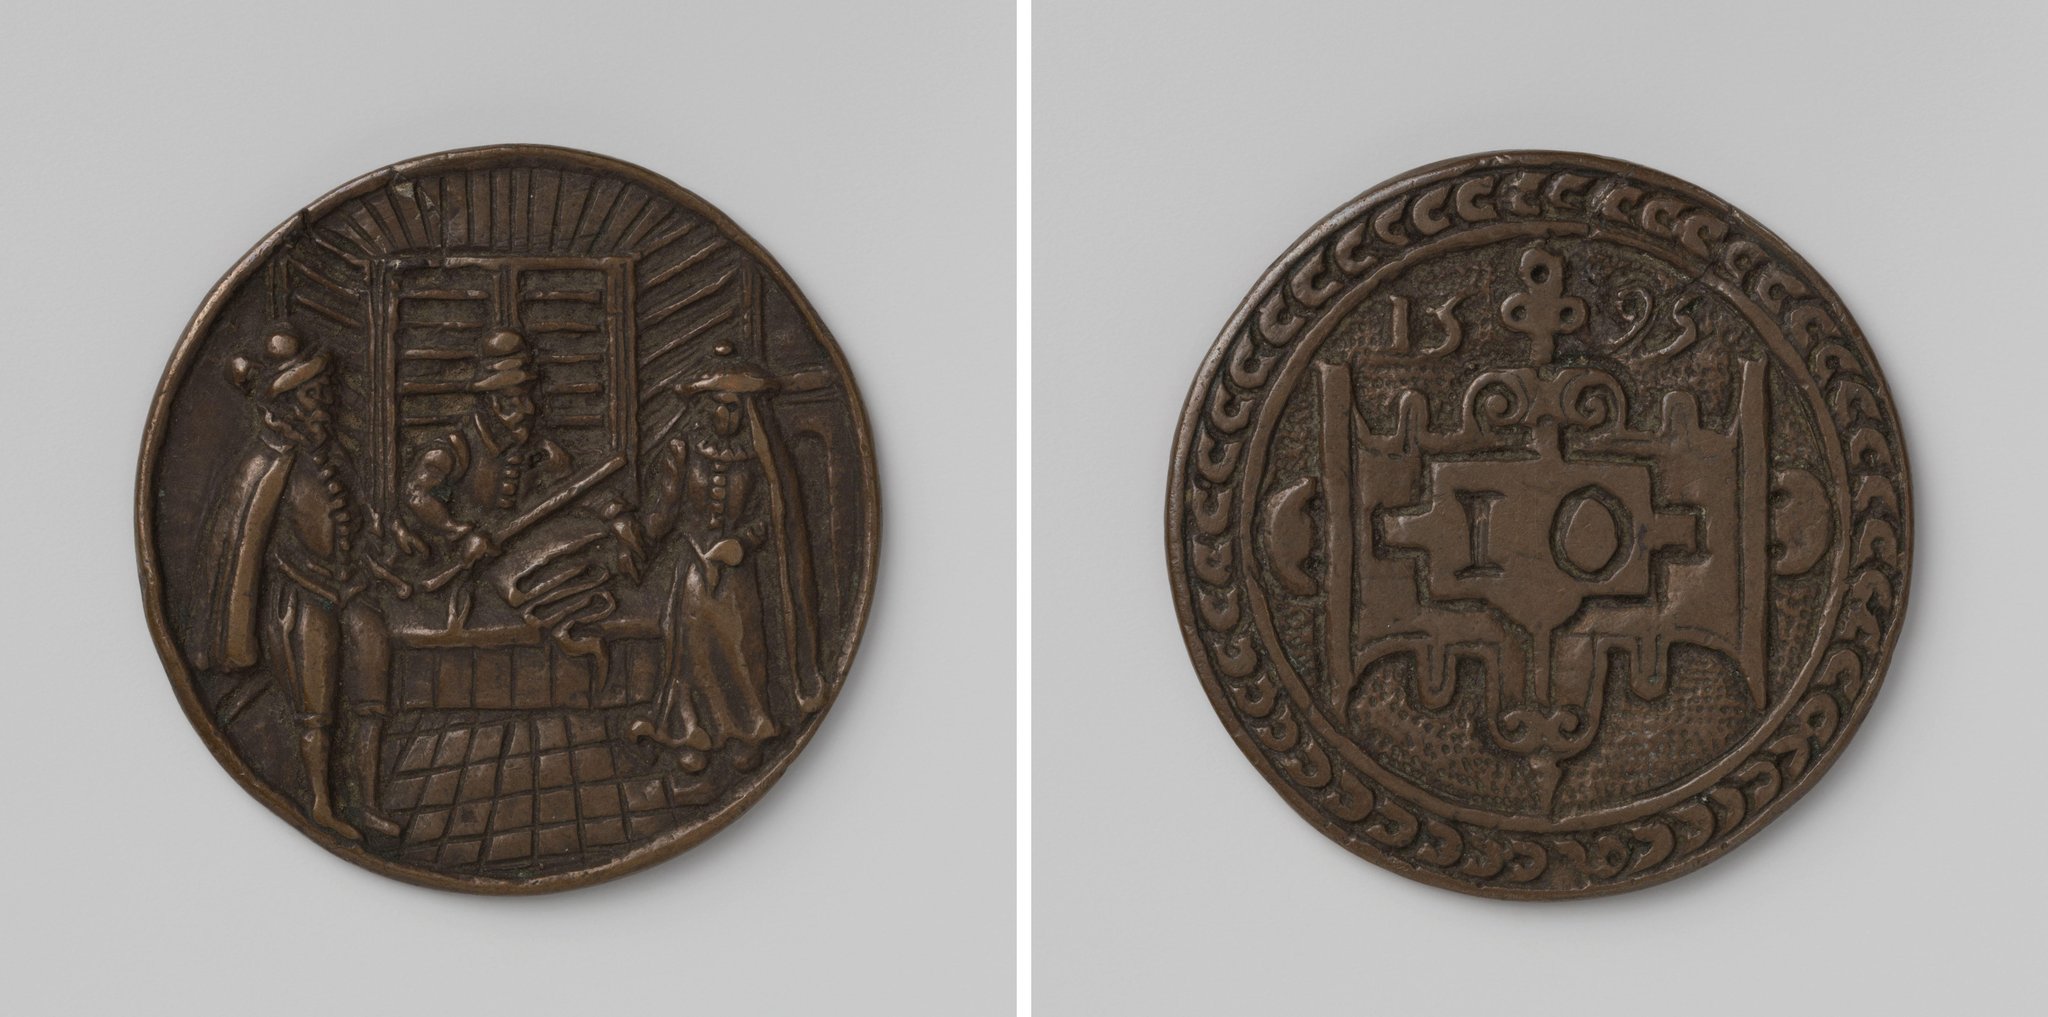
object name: medal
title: Wollenlakenkopers- en -snijdersgilde van Middelburg, gildepenning met no. 10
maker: francois baillet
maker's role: medailleur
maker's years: 1595-1603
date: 1595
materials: copper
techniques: casting, engraving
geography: middelburg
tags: middelburg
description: Koperen penning. Voorzijde: lakenkoopman, staande achter toonbank in zijn winkel meet met een el stof; links en rechts: man en vrouw. Keerzijde: cijfer 10 in versierd compartiment onder jaartal binnen rand van sikkels